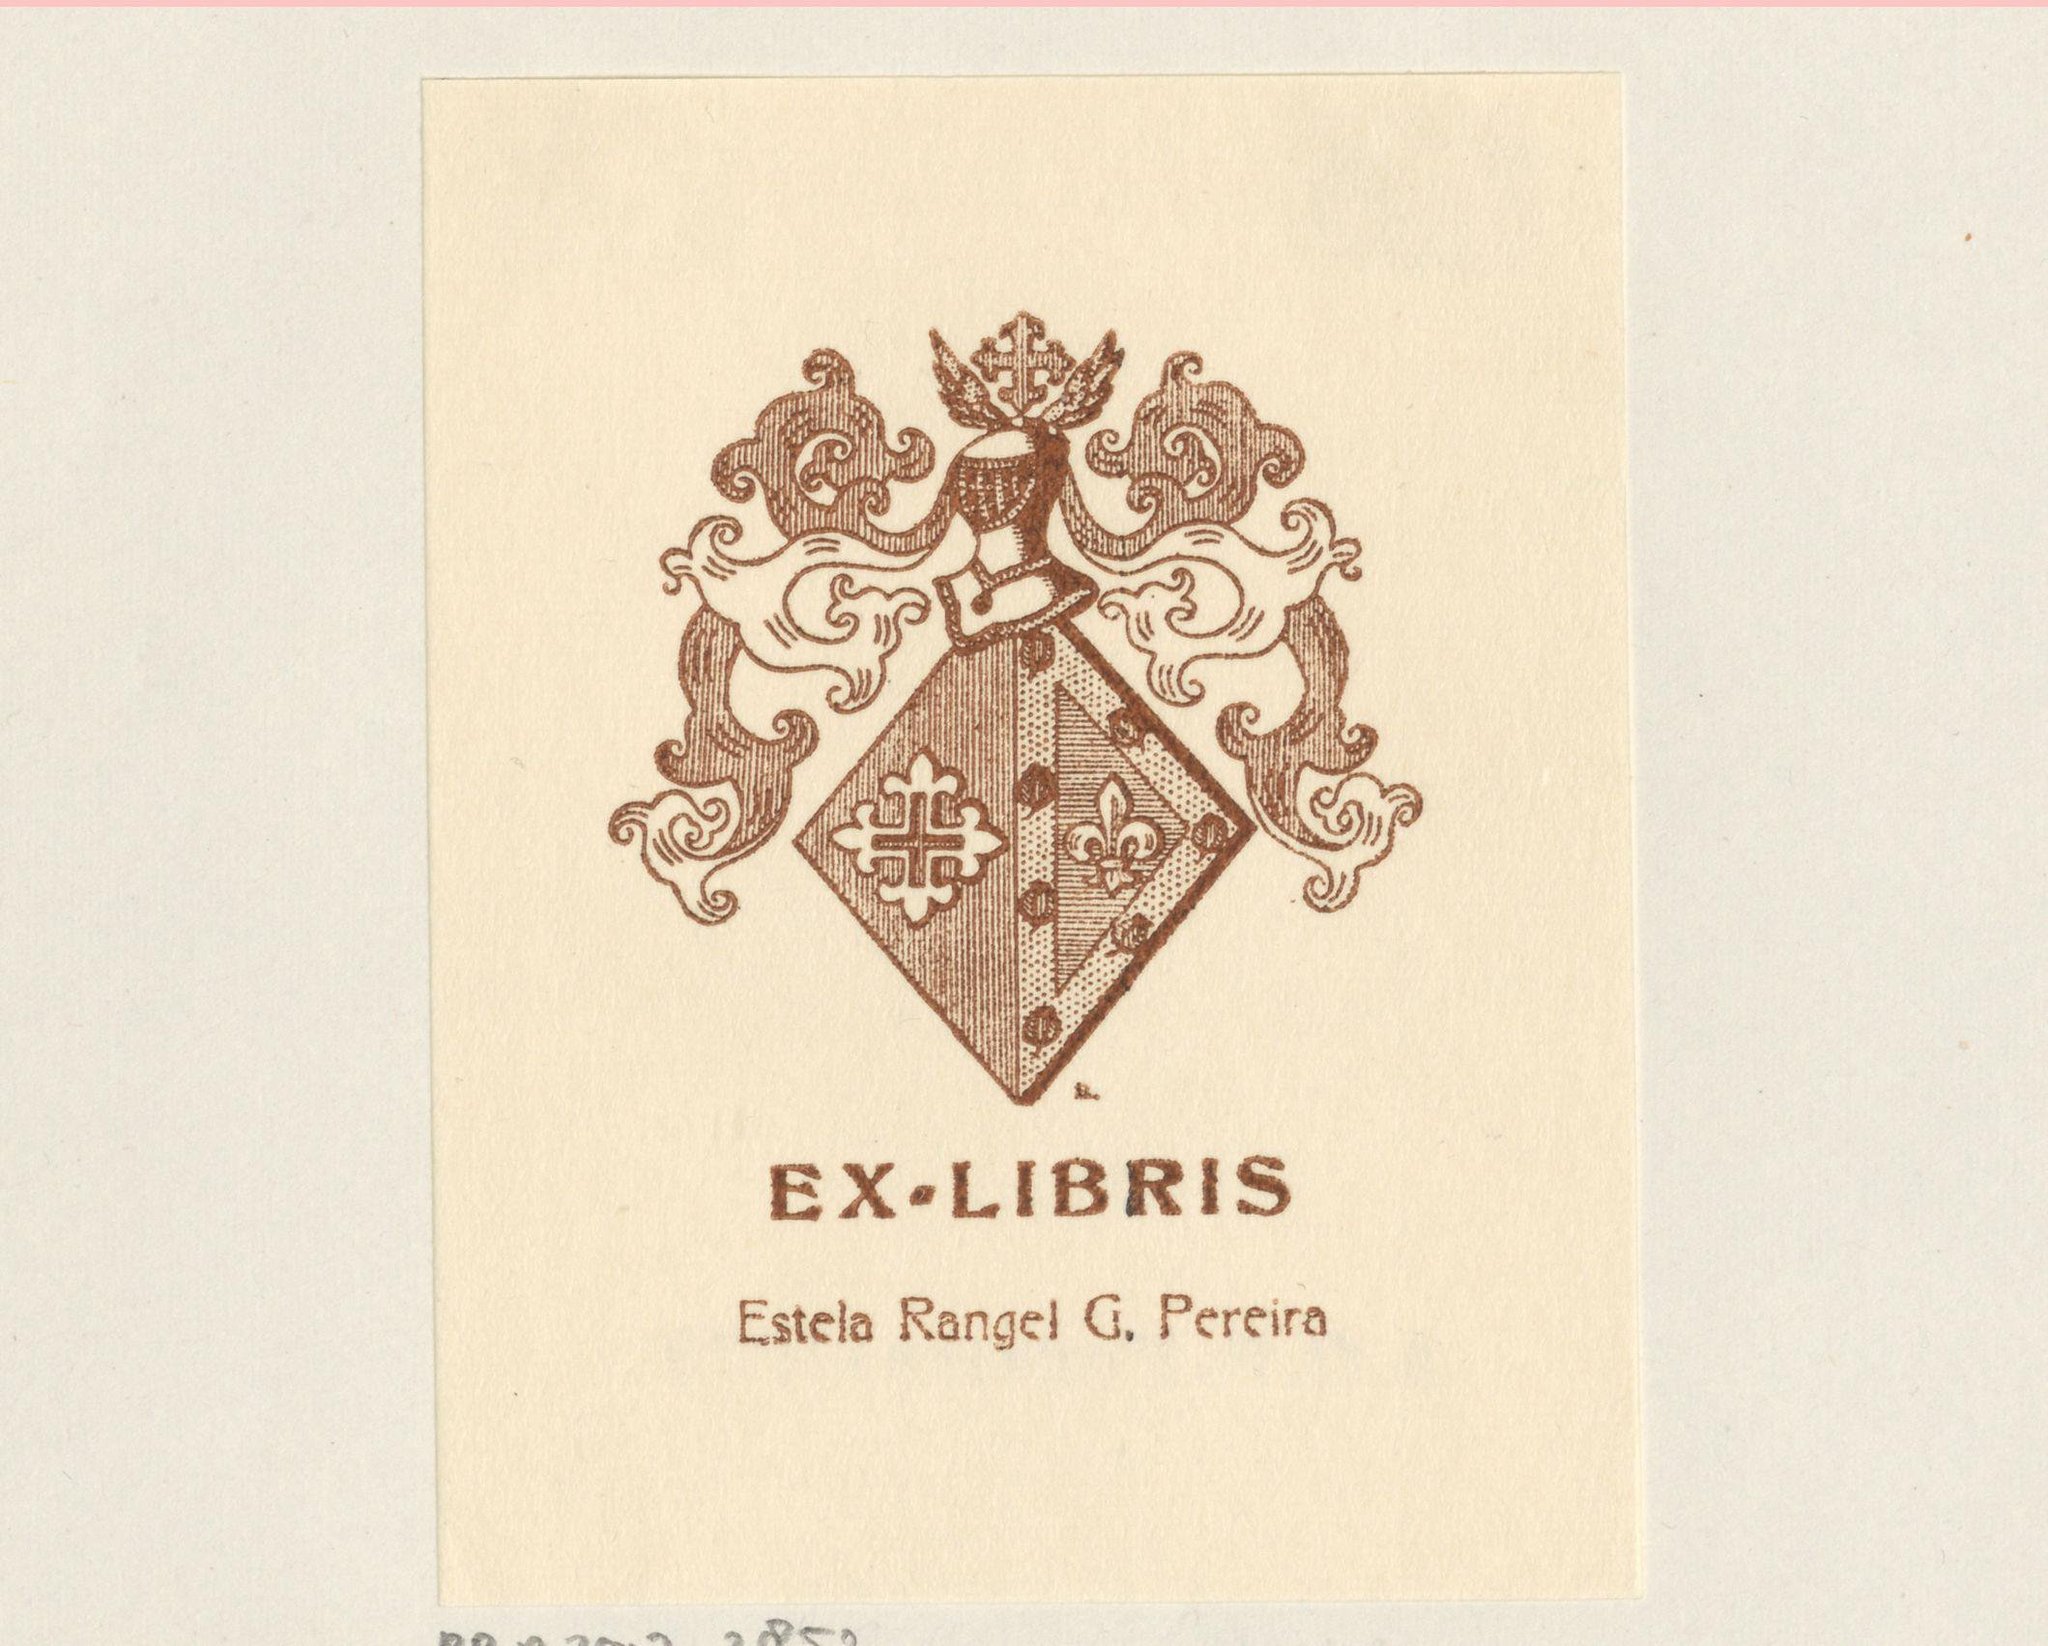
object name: bookplate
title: Ex libris van Estela Rangel G. Pereira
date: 1933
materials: paper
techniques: printing block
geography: portugal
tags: armorial bearing, heraldry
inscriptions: workshop stamp: ‘A.G.R. Pereira 1933’